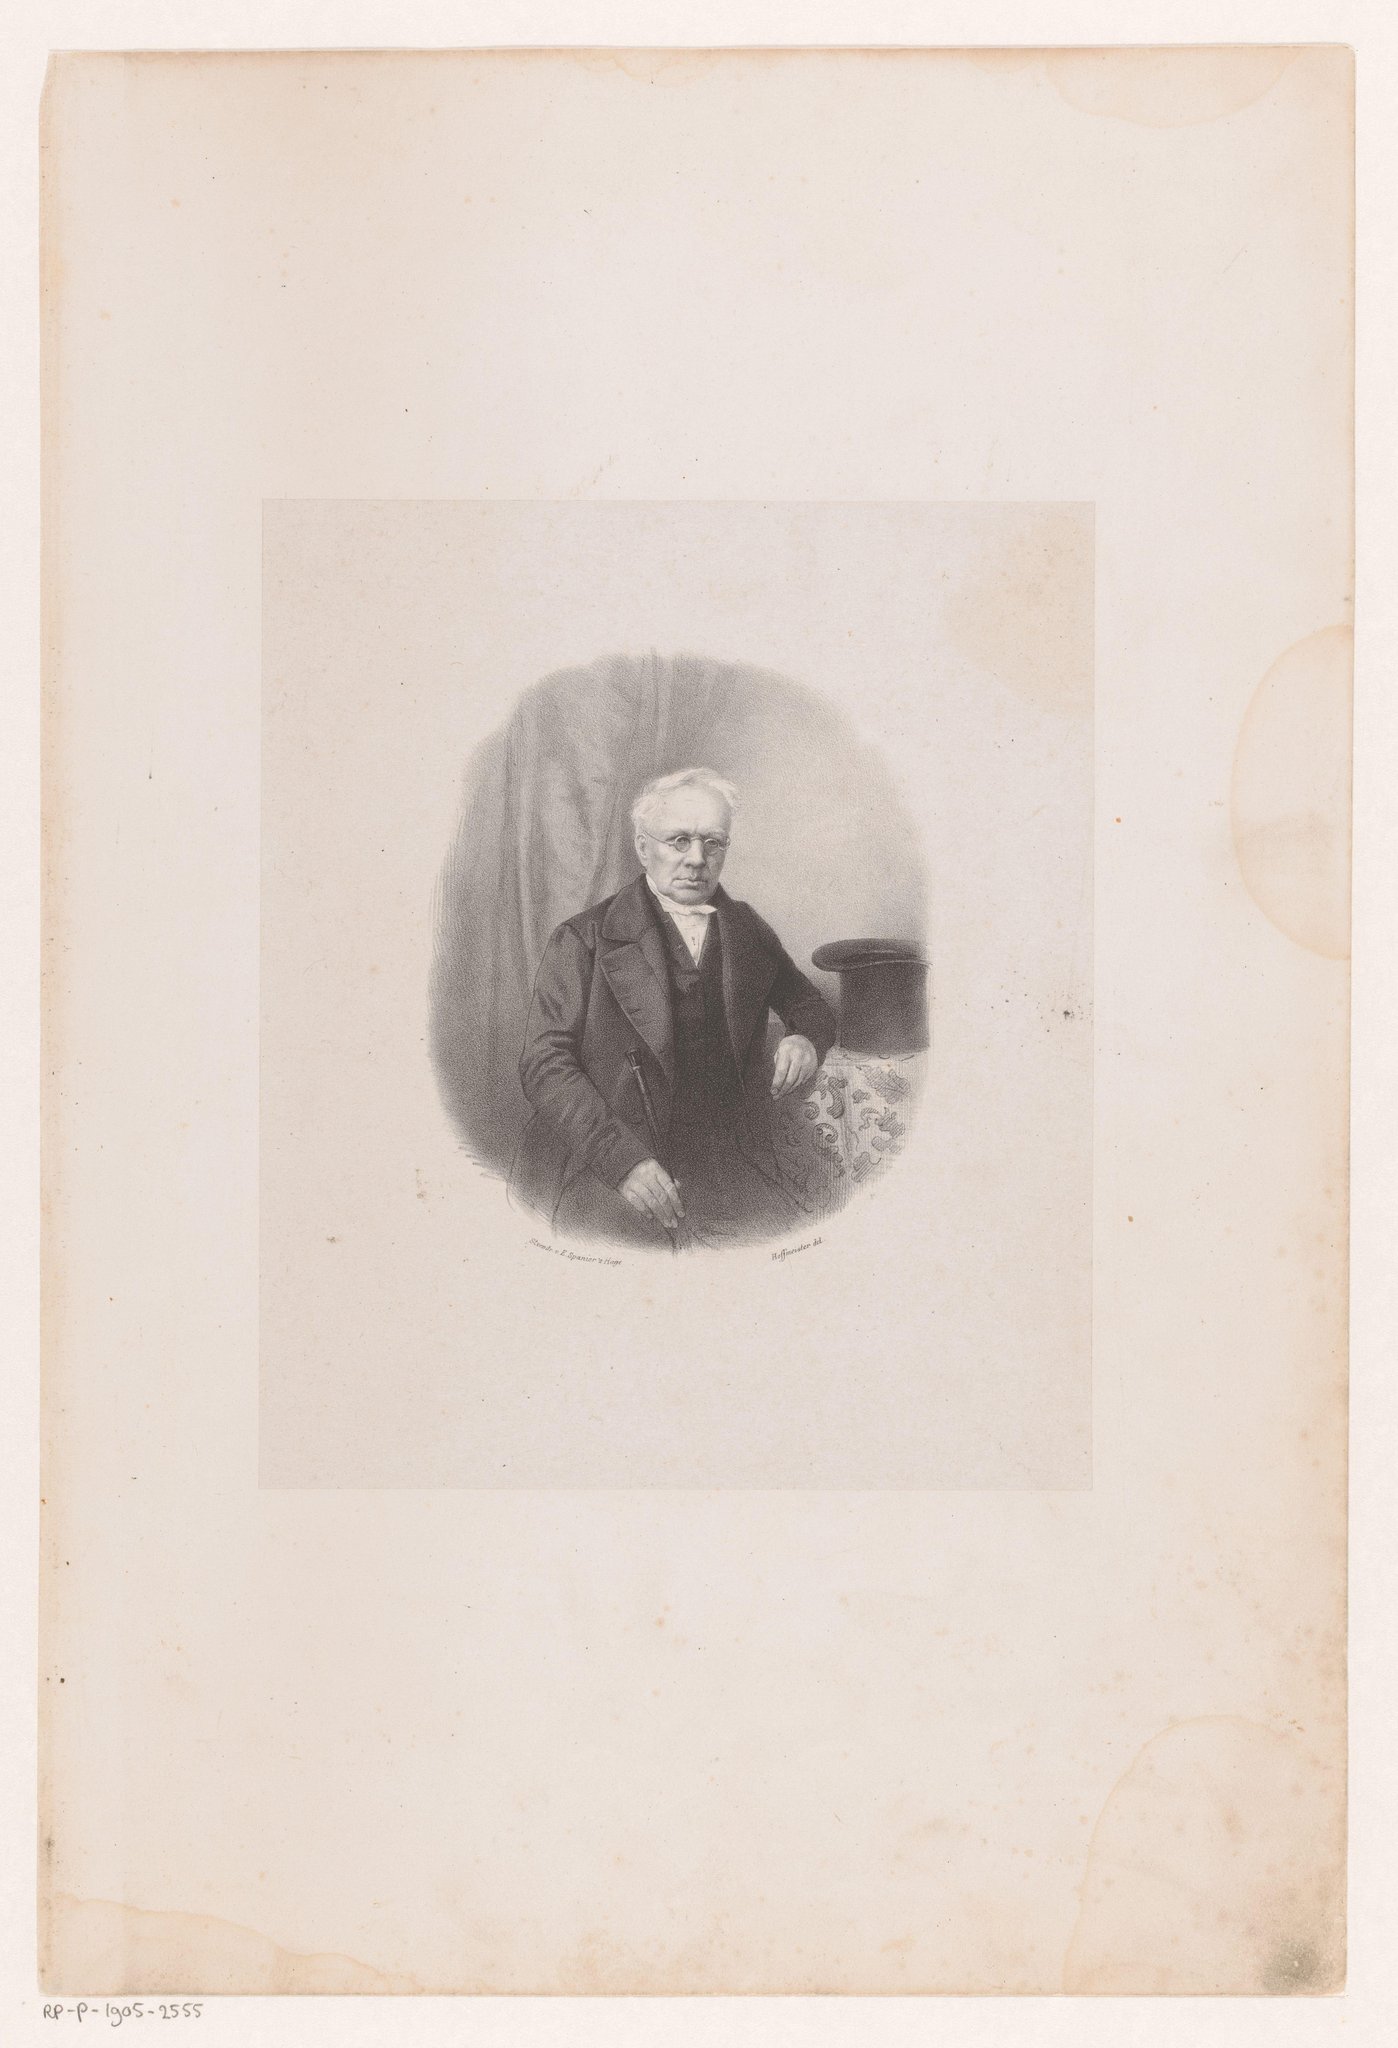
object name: print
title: Portret van een onbekende man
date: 1843-1863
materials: paper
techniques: lithograph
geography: the hague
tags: eyeglasses, spectacles, walking-stick, staff, historical persons (+ half-length portrait), head-gear: top hat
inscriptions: collector's mark: Lugt 2228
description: De geportretteerde zit op een stoel. Hij draagt een bril en heeft een wandelstok in zijn rechterhand. Naast hem, op de tafel, ligt een omgekeerde hoge hoed.